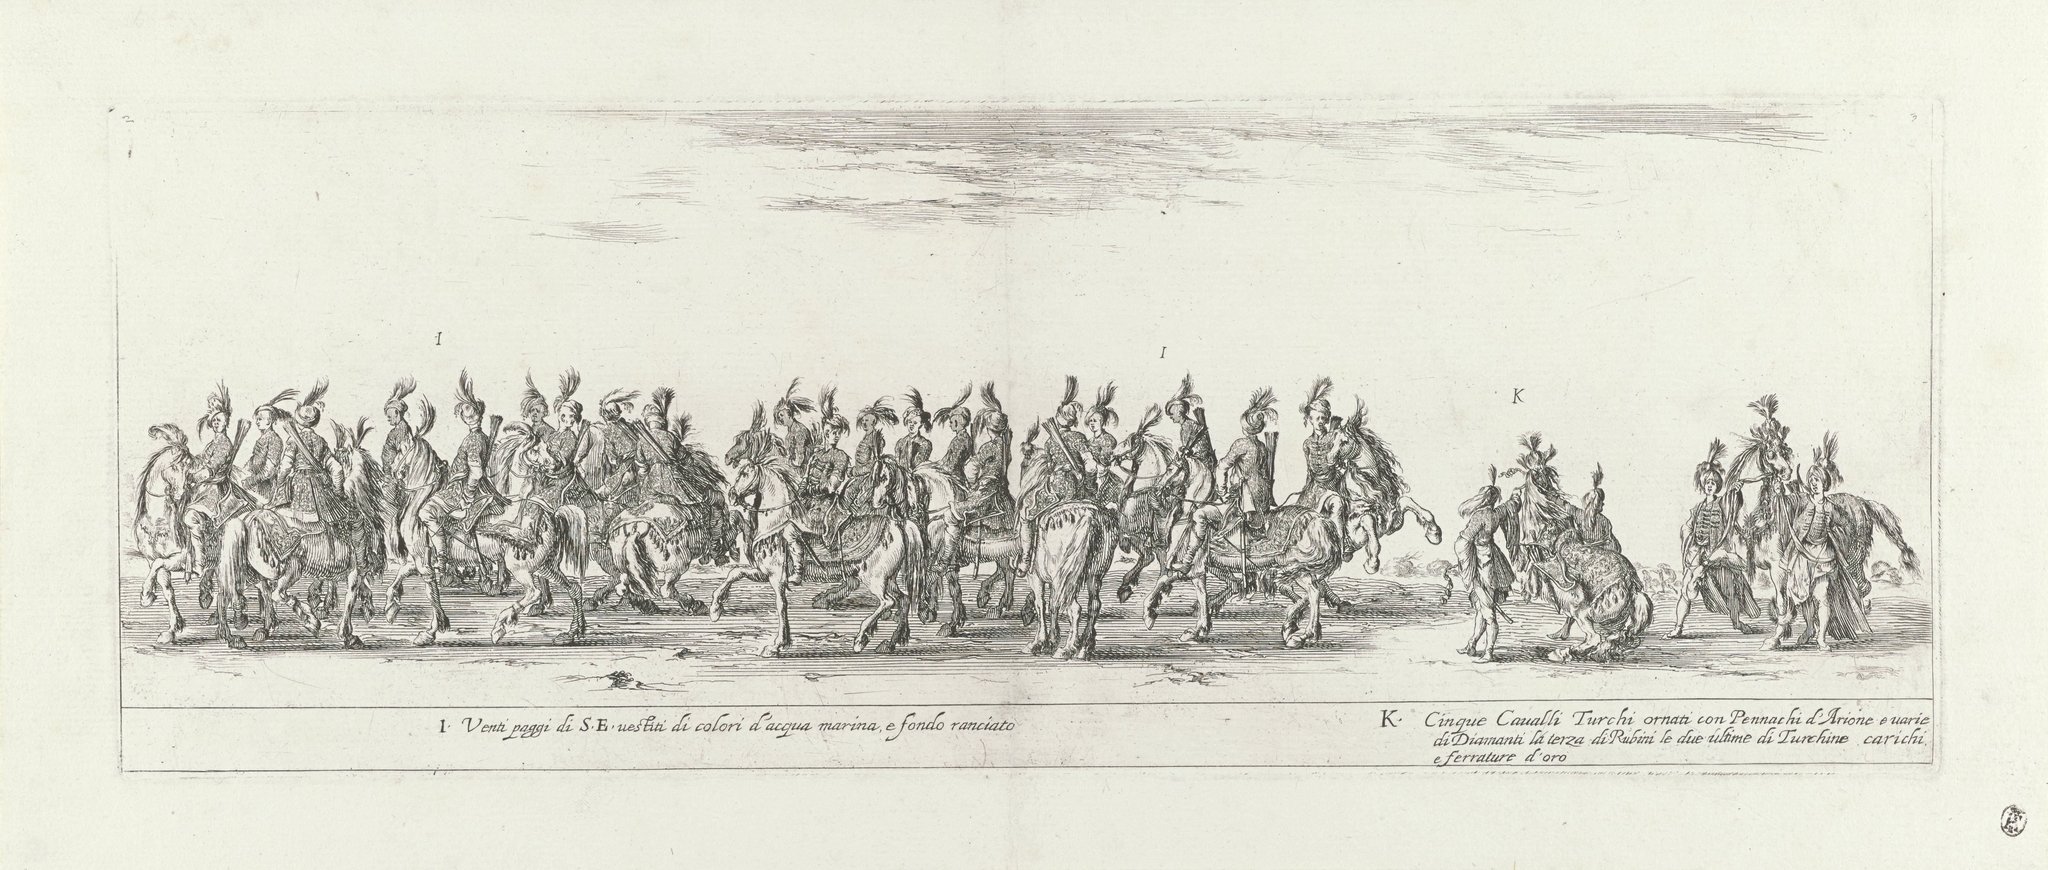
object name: ornament print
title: Deel van een processie met mannen te paard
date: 1620-1664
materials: paper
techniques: etching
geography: rome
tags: triumphal entry and public reception, pageant, 'entrée solennelle', 'joyeuse entrée'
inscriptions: collector's mark: Lugt 971, collector's mark: Lugt 2228, collector's mark: Lugt 533b, collector's mark: Lugt 2760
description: Deel van een processie met mannen te paard. Legenda (I-K) in het Italiaans in de ondermarge. Linksboven: 2, rechtsboven: 3.